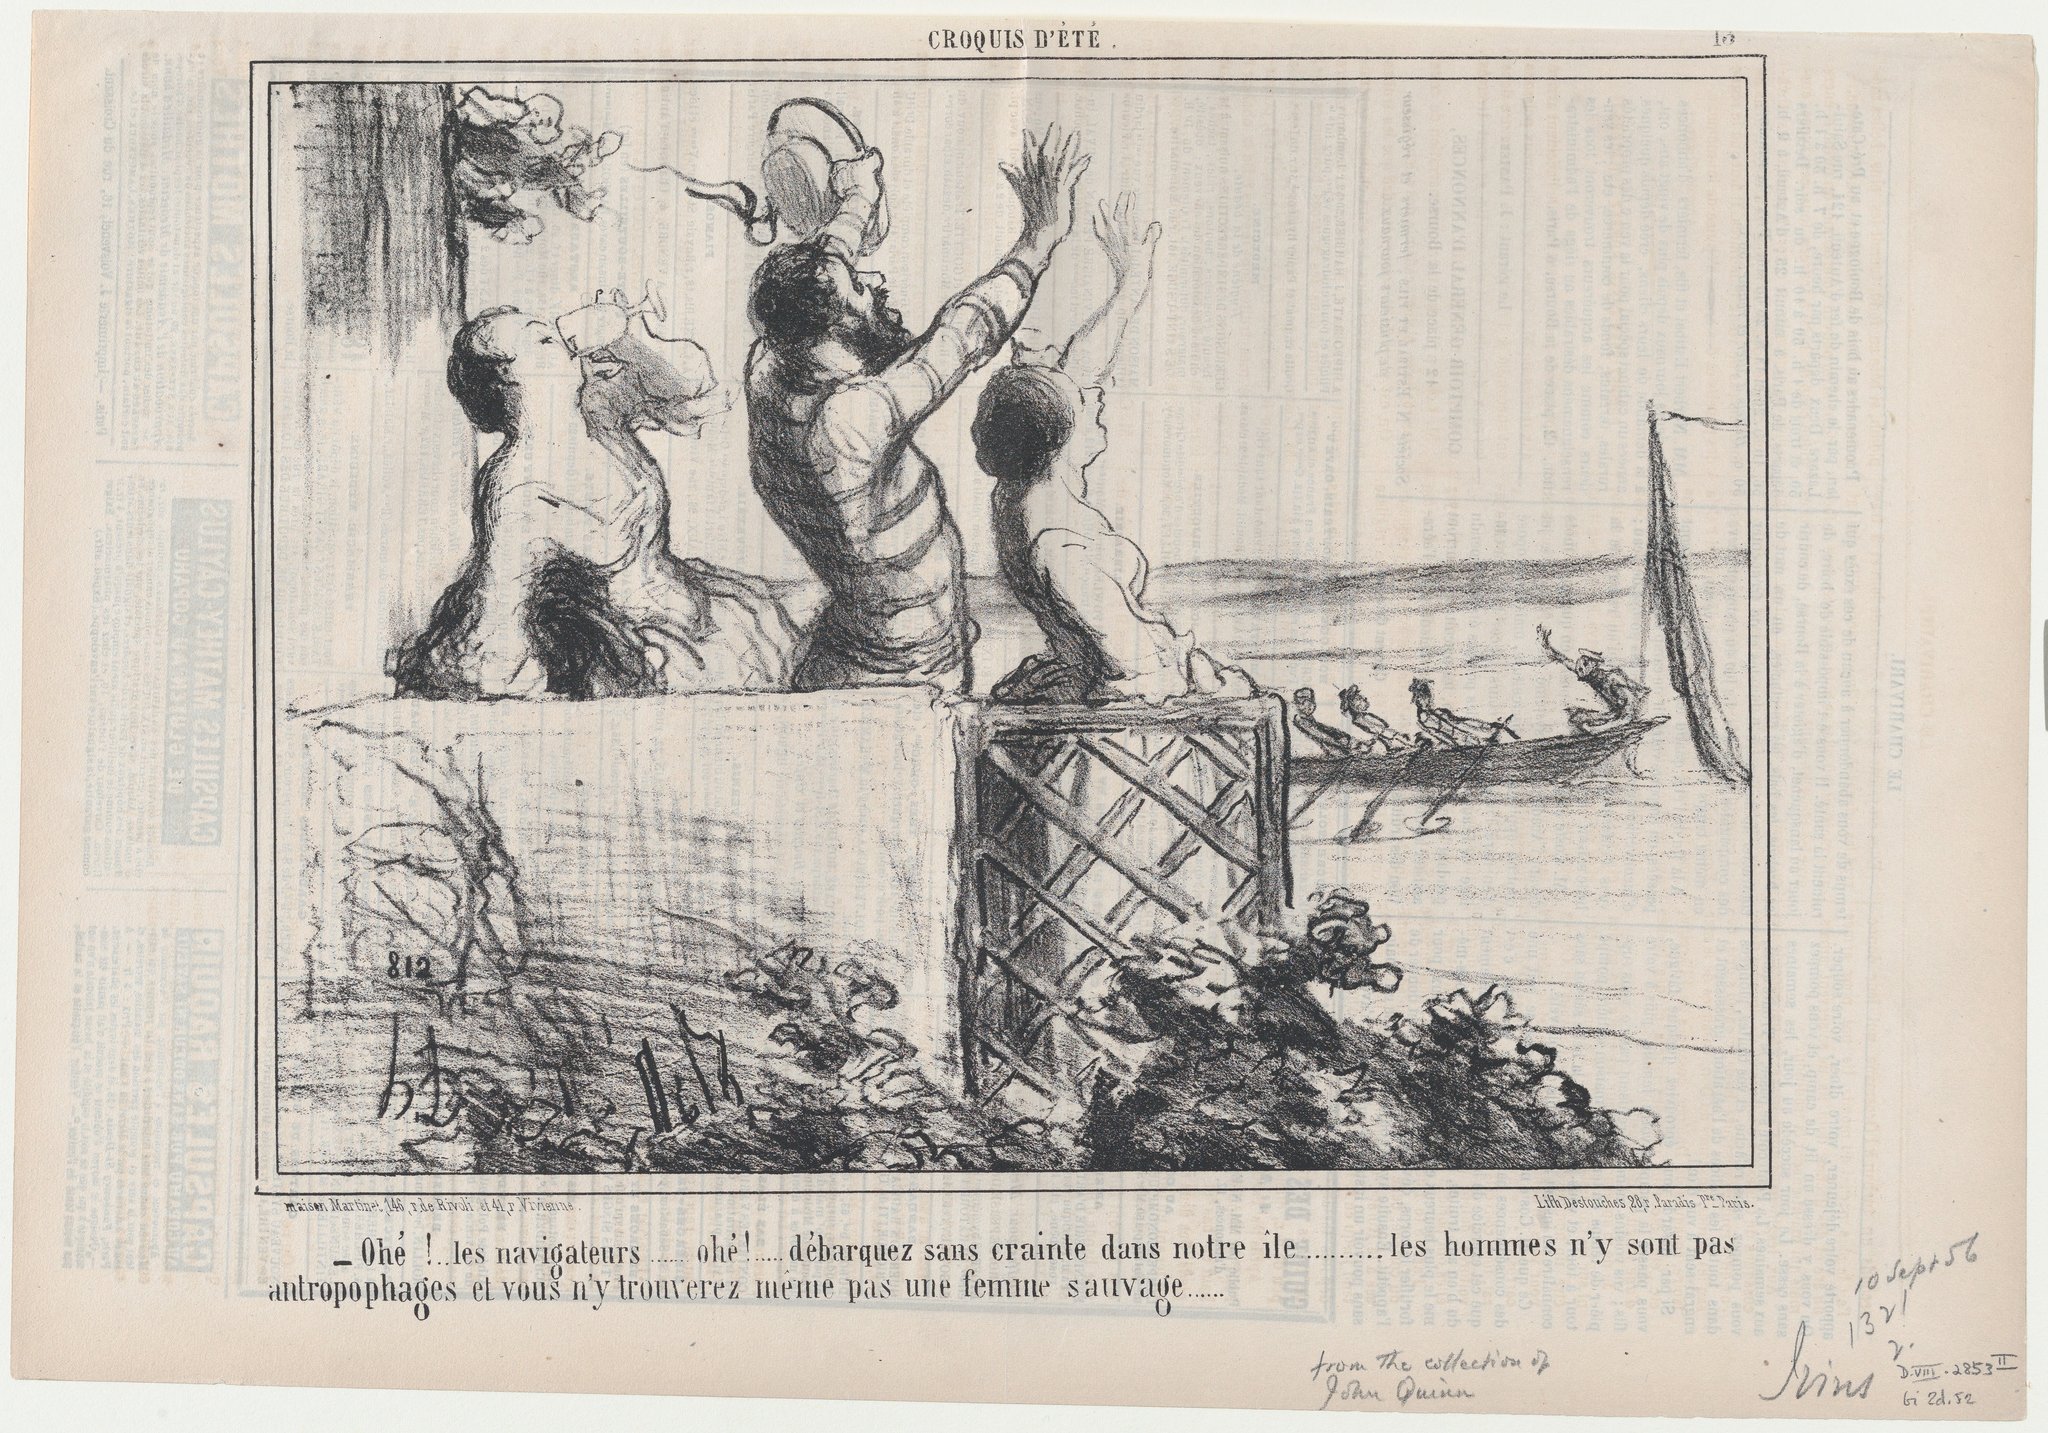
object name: print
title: Ohé...les navigateurs...débarquez sans crainte..., from Croquis d'Été, published in Le Charivari, September 10, 1856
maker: honoré daumier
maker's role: artist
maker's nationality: french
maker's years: 1808-1879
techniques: lithograph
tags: men,women,boats